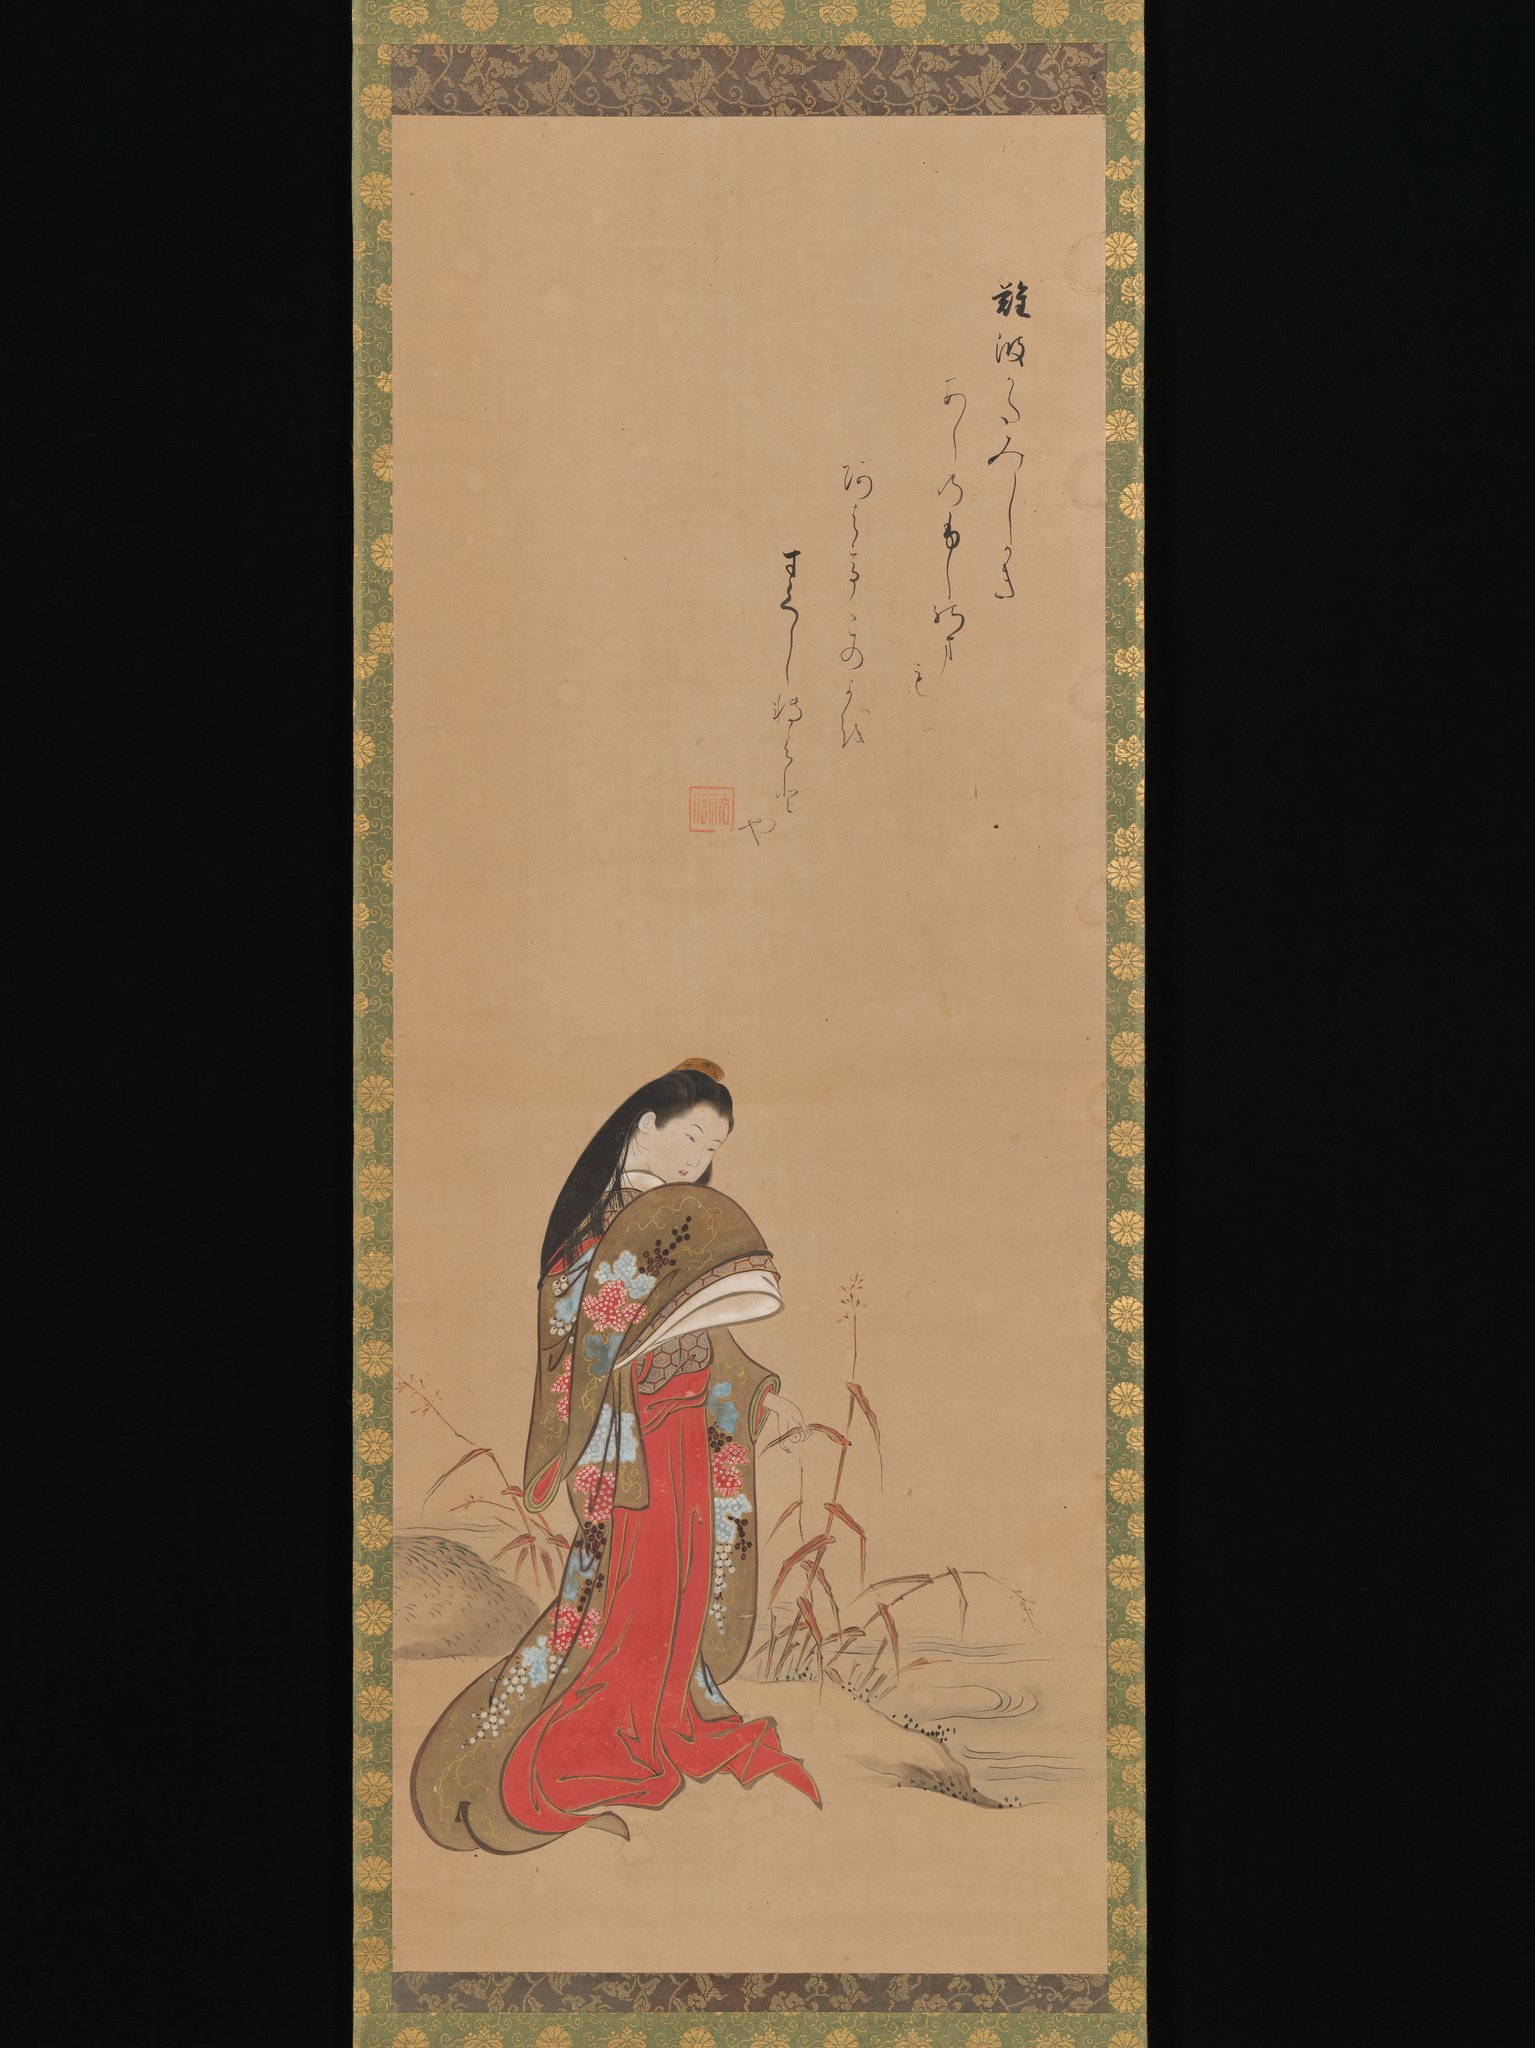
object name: hanging scroll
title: Lady Ise by the Riverbank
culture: japanese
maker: nishikawa sukenobu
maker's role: artist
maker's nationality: japanese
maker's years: 1671-1750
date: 1767-1800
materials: ink, paper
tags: women